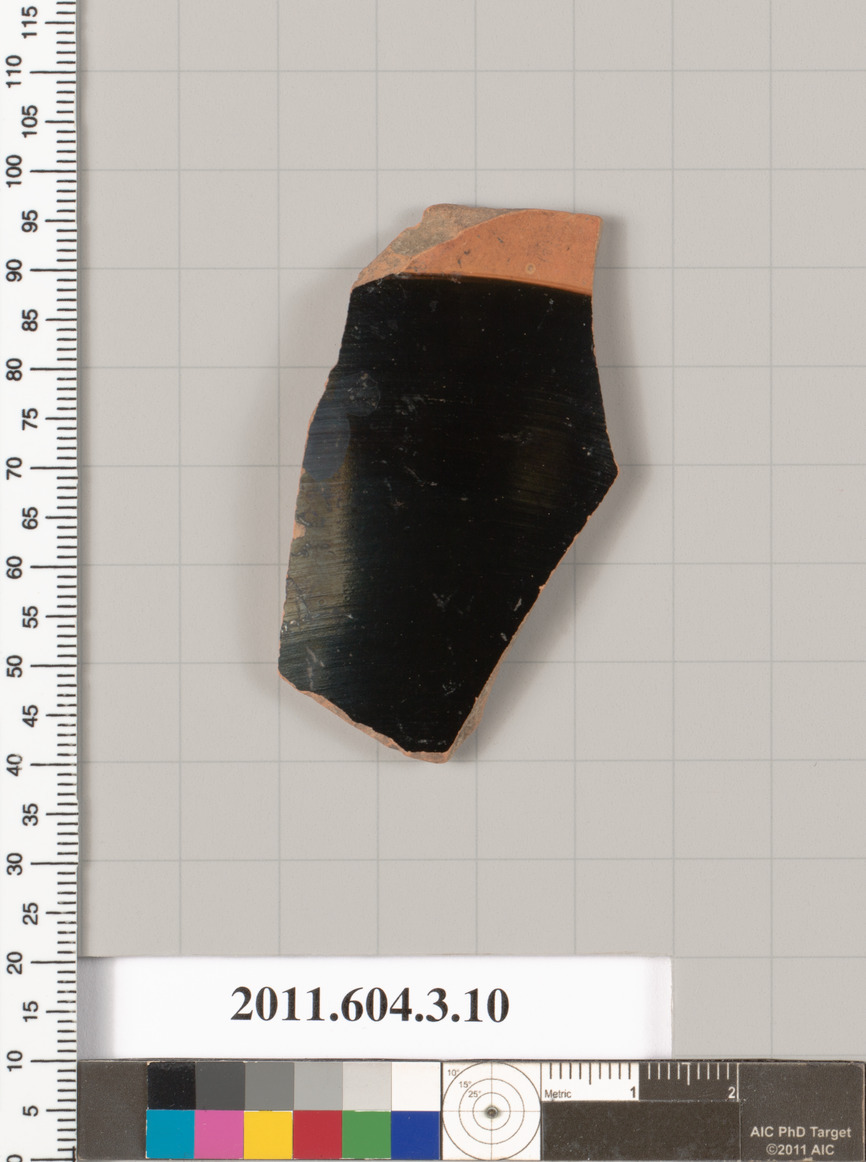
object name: kylix fragment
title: Terracotta fragment of a Little Master cup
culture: greek, attic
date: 550-525 BCE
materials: terracotta